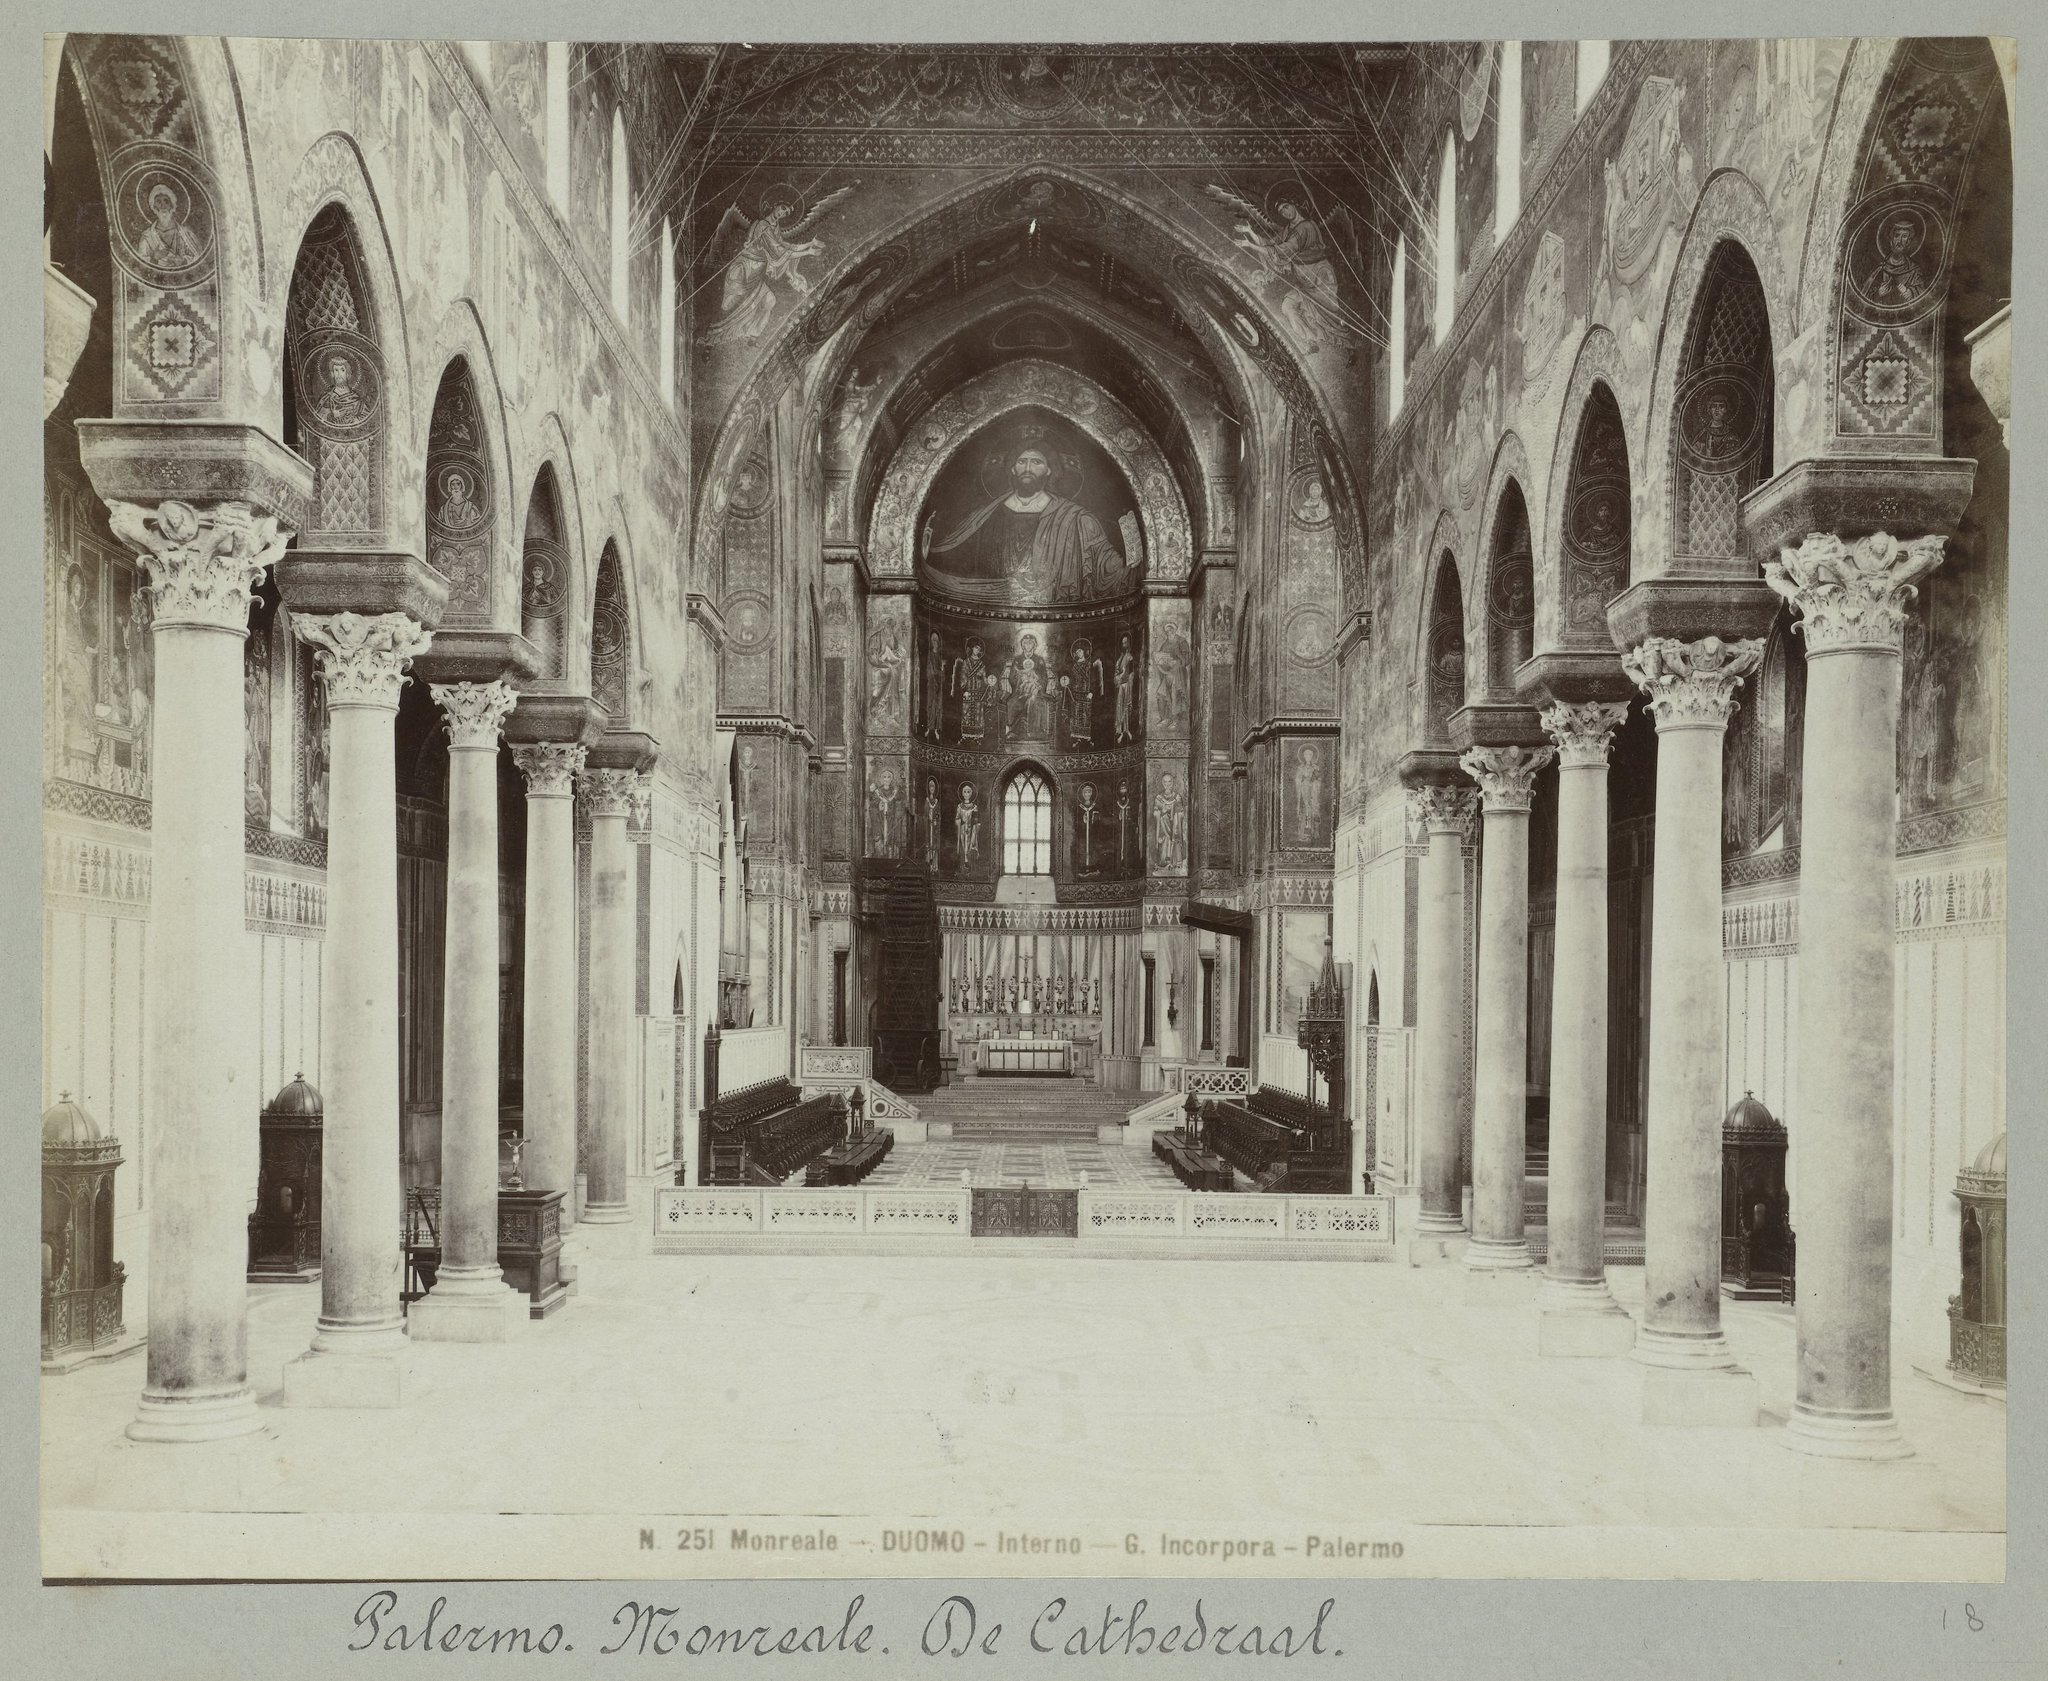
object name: photograph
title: Palermo Monreale. De Cathedraal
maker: giuseppe incorpora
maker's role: fotograaf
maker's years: 1834-1914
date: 1893-1903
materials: cardboard, photographic support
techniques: albumen print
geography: palermo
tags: monreale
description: Het interieur van de domkerk in Monreale.